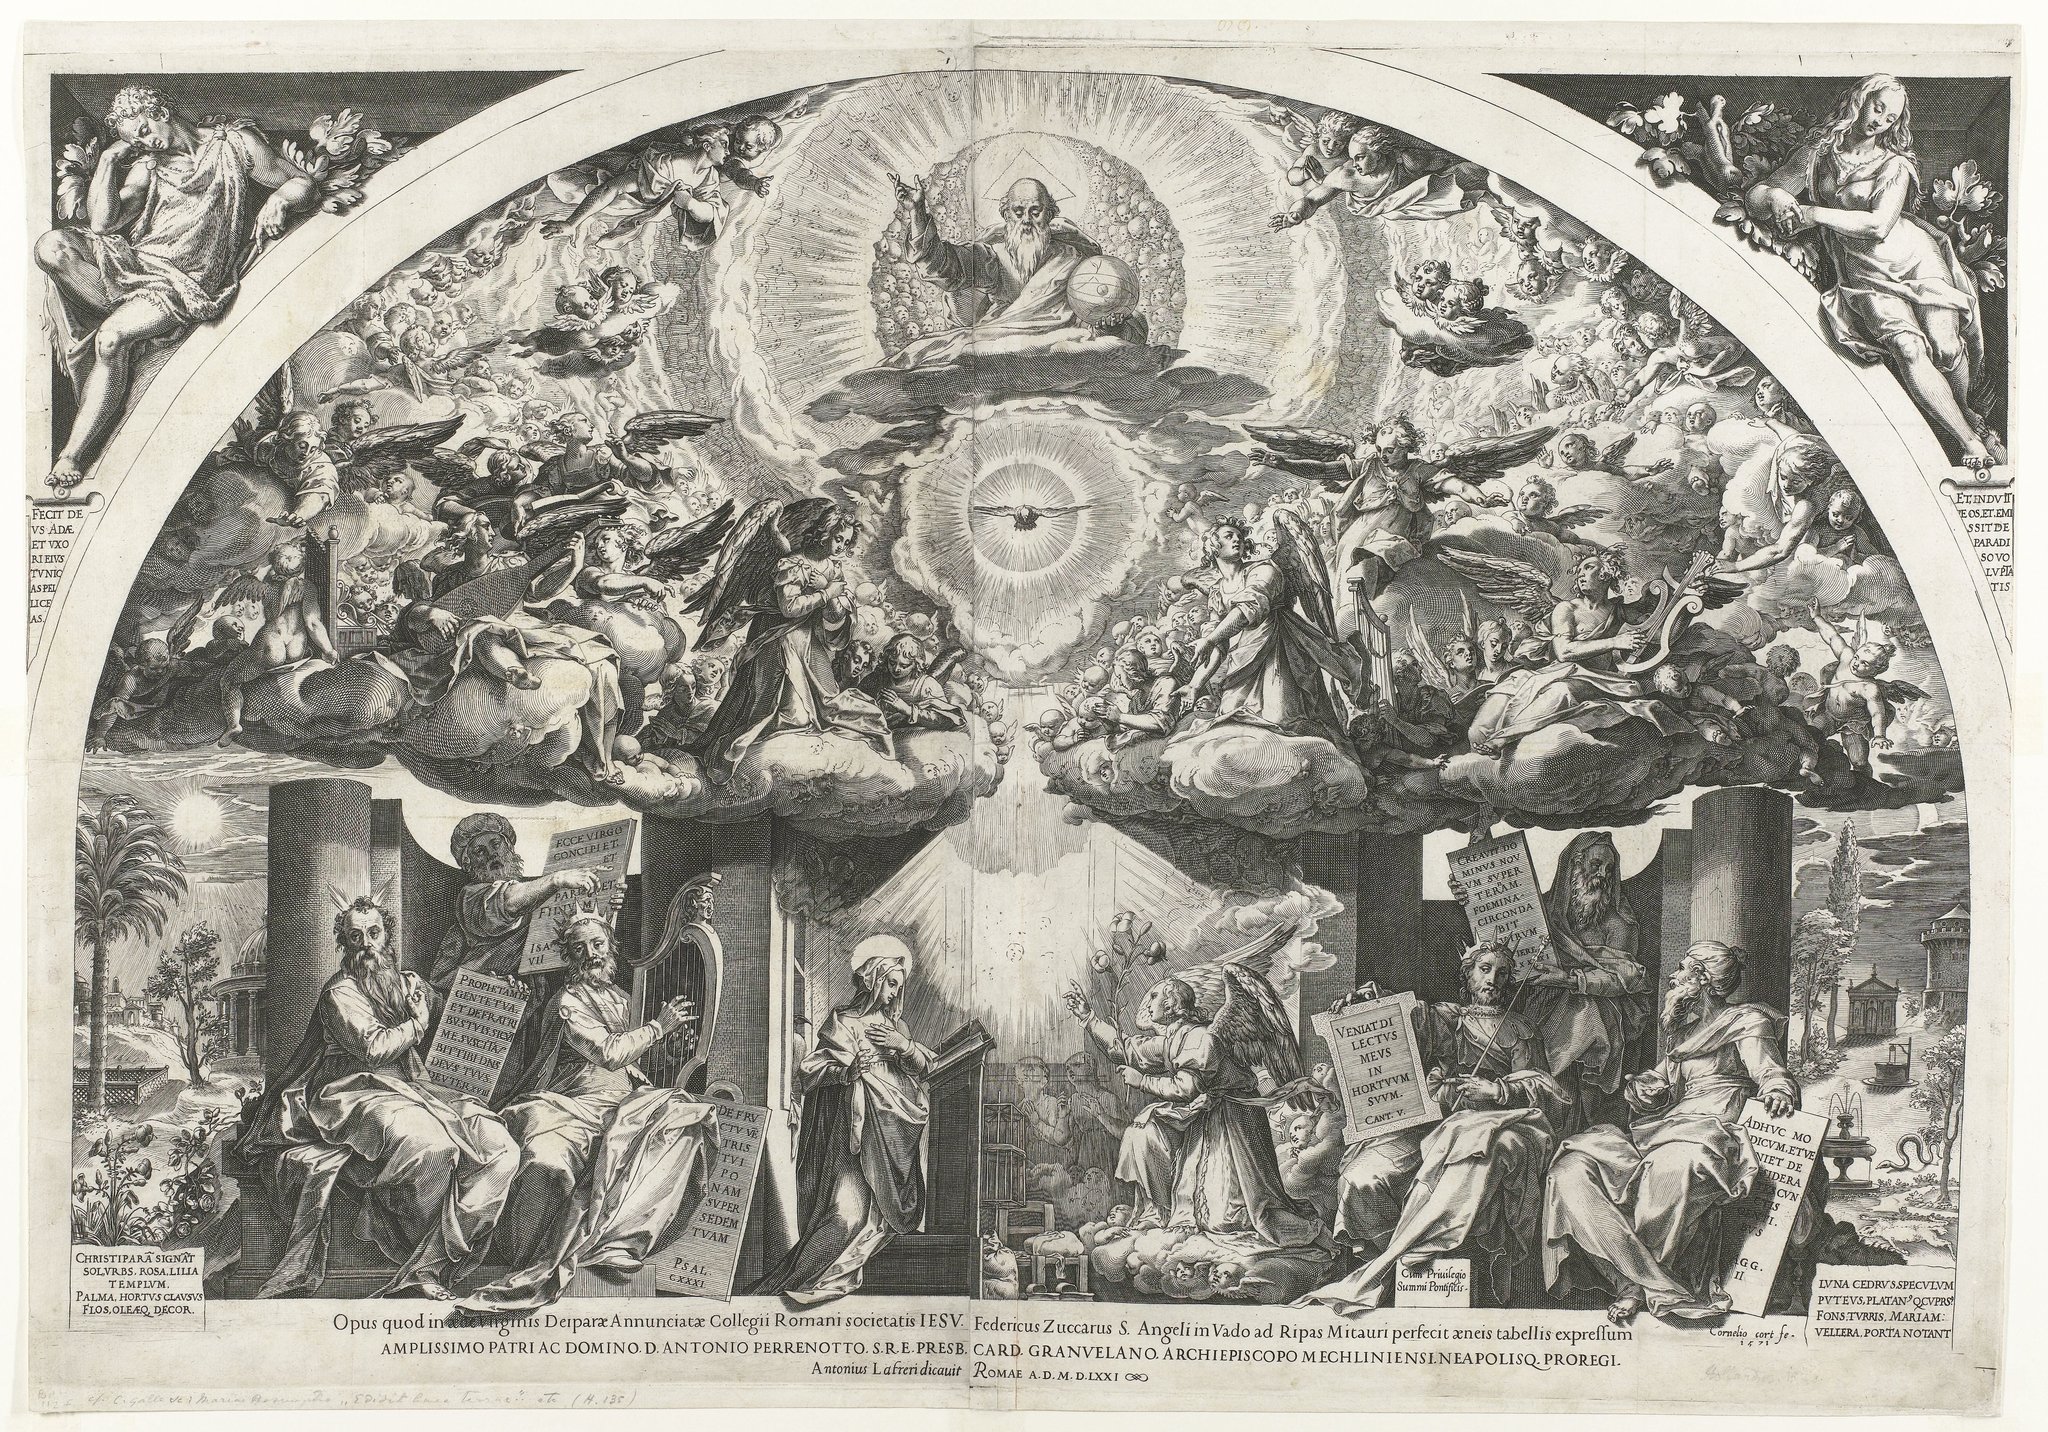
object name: print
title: Annunciatie, omgeven door profeten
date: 1571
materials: paper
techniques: engraving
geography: rome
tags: the annunciation: mary kneeling, the twelve apostles ~ the twelve prophets, angels singing, making music, god the father represented as human being, usually with crown or tiara or sceptre and/or globe, holy ghost represented as a dove (in flames)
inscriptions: date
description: In het midden de geknielde Maria, met voor haar de knielende engel met een lelie in de hand. Links en rechts profeten. Boven hen engelenkoren in de wolken, in het midden in een stralenkrans, God de Vader als oude man met wereldbol en de H. Geest in de gedaante van een duif.